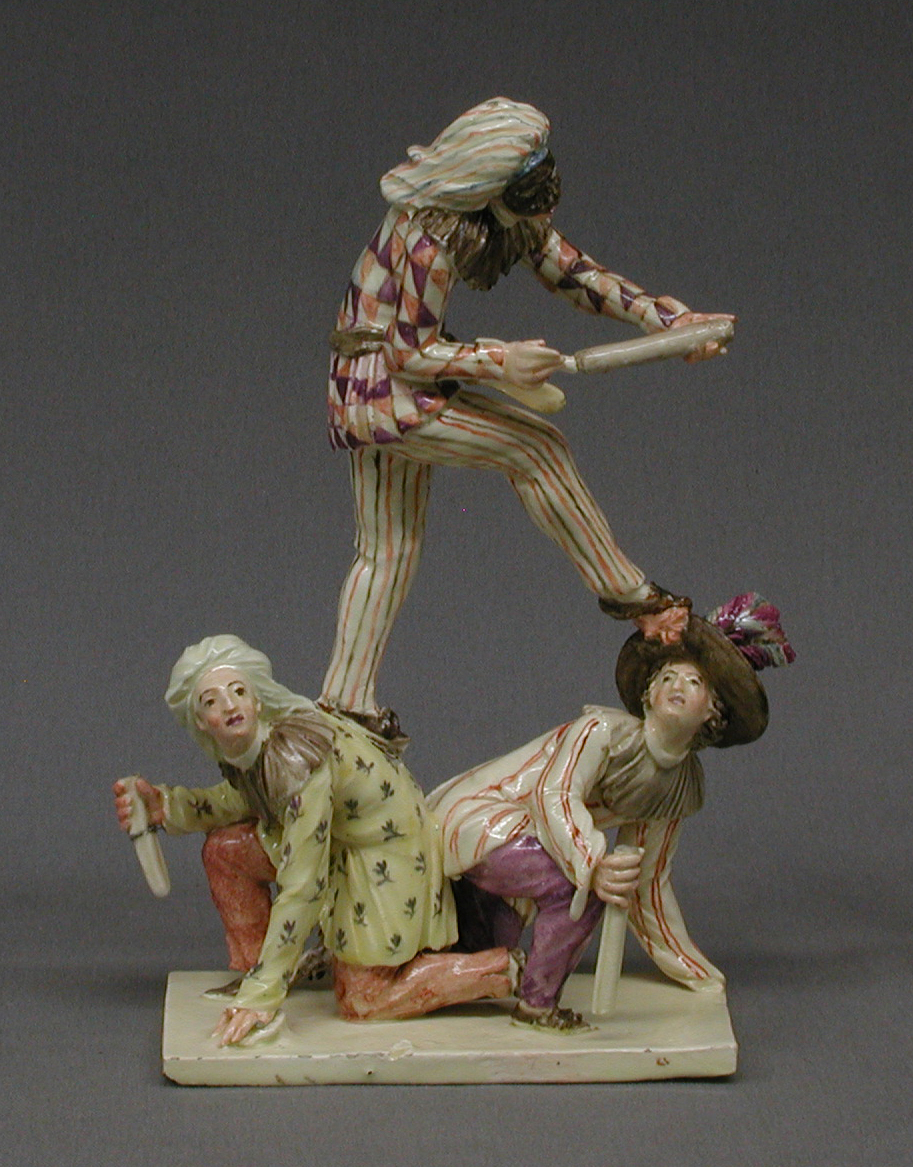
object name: figure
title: Acrobats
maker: le nove porcelain manufactory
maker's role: manufactory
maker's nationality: italian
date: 1780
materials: creamware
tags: men,women,acrobats